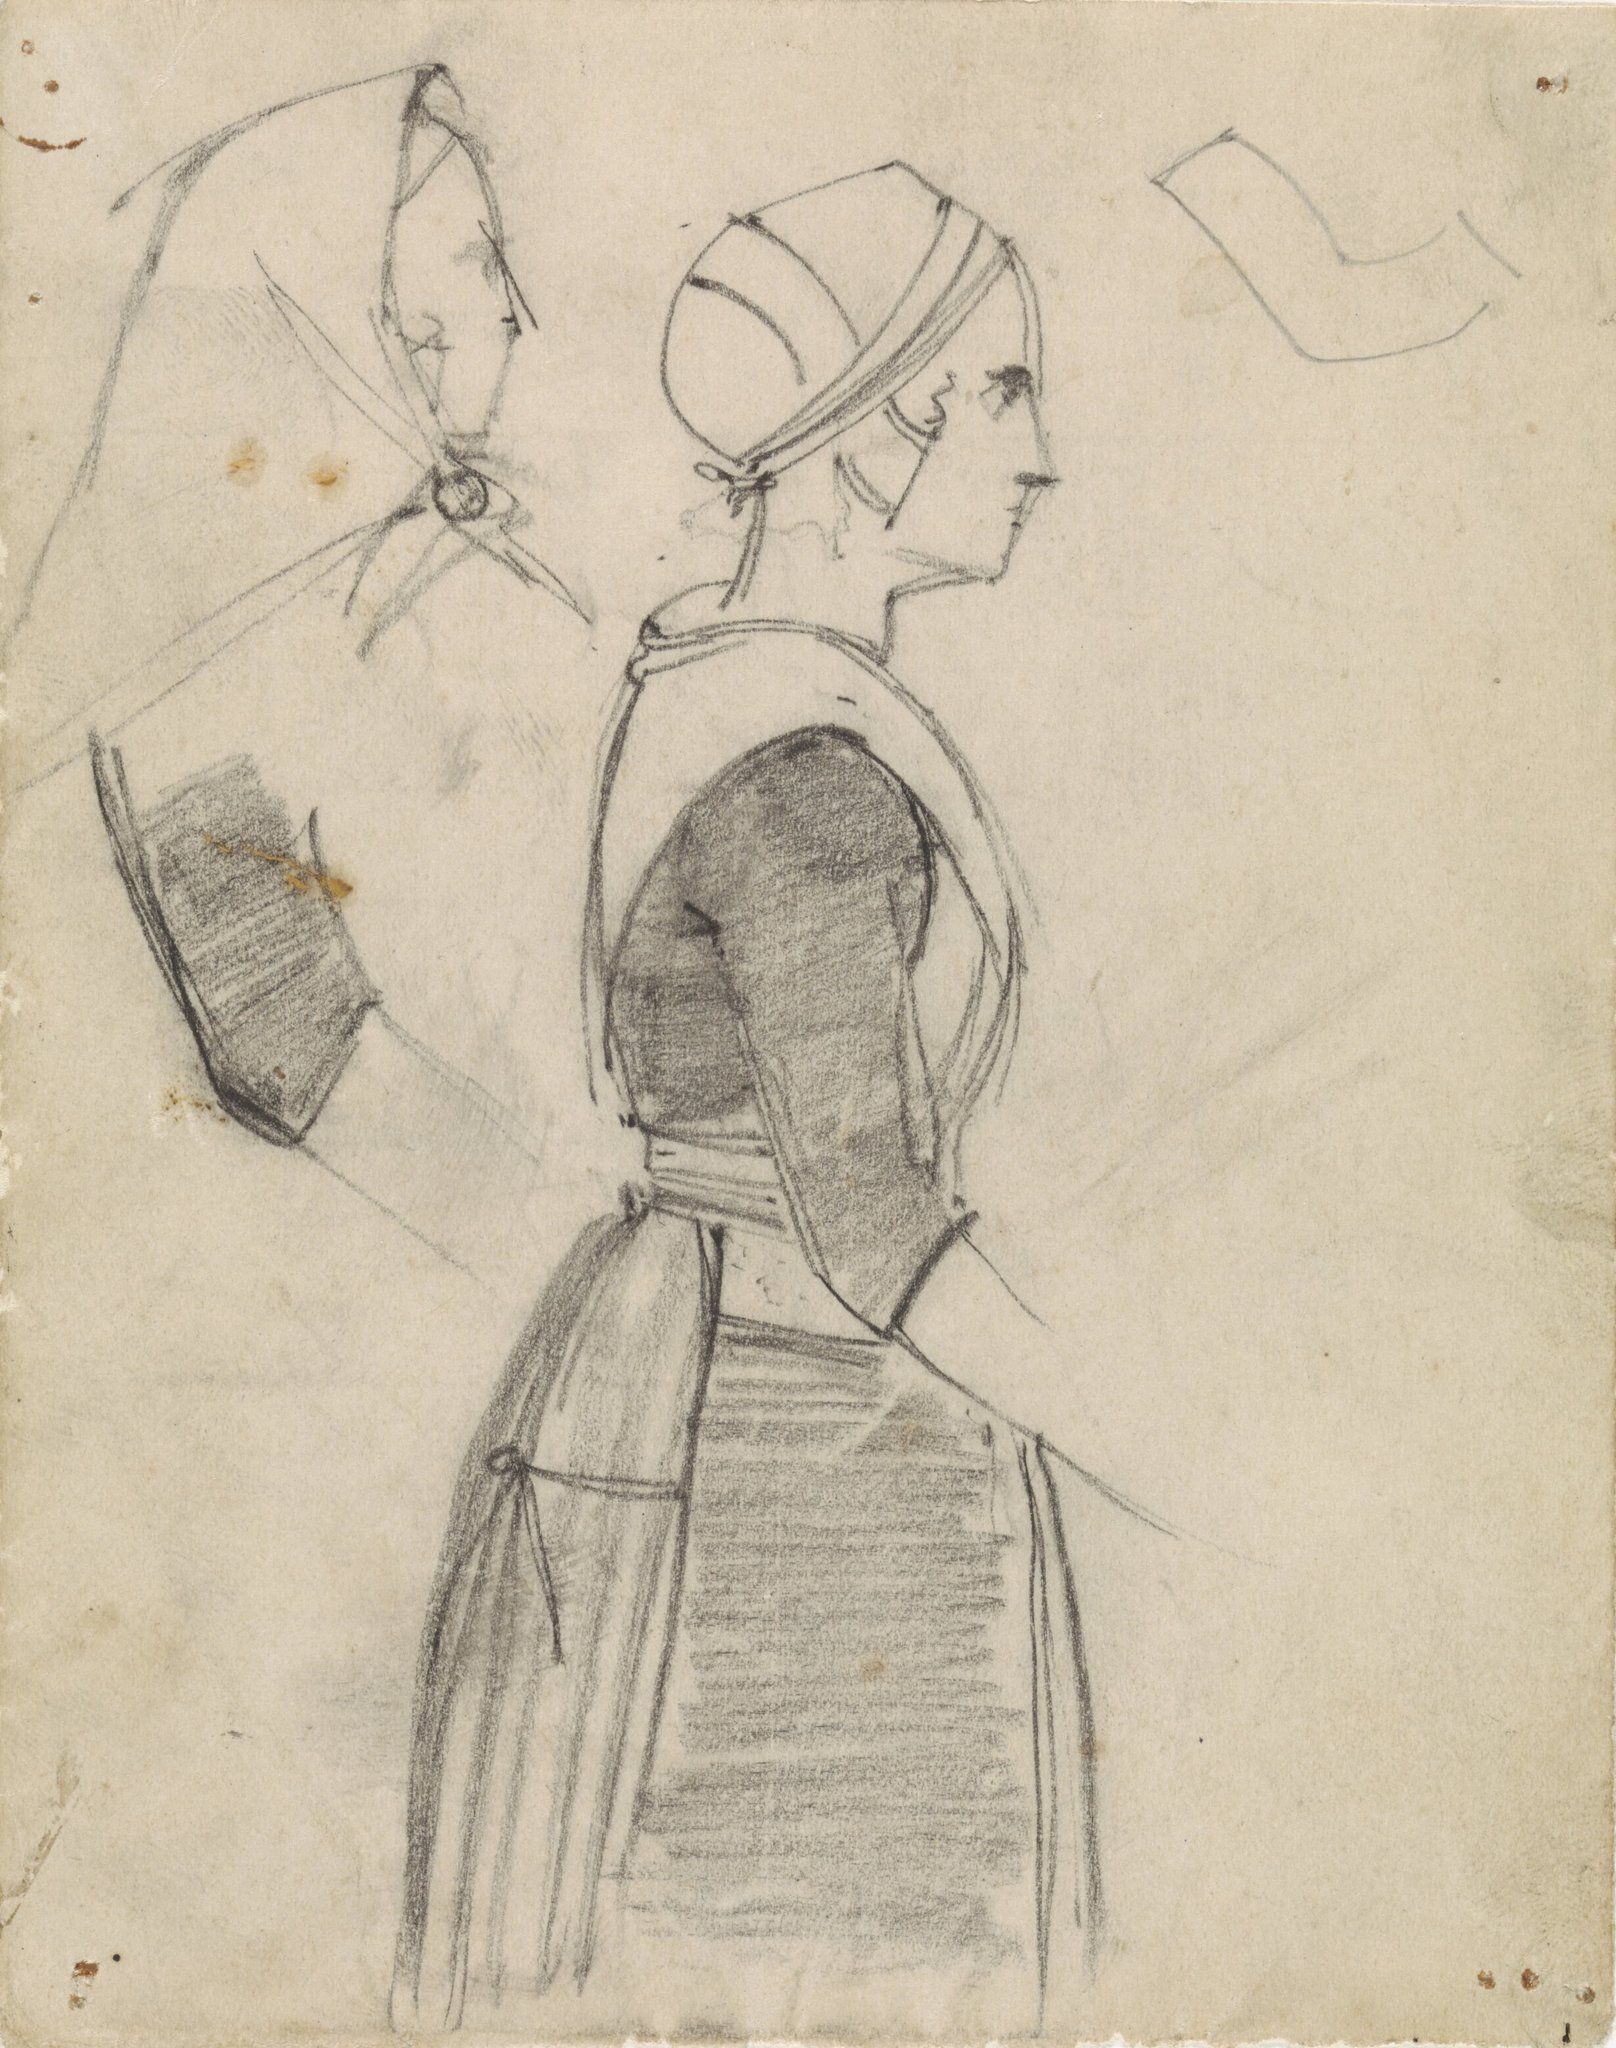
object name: drawing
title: Studie van een vrouw in Spakenburger dracht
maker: gerrit willem dijsselhof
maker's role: designer, draughtsman, print maker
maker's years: 1866-1924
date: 1876-1924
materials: chalk, paper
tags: folk costume, regional costume